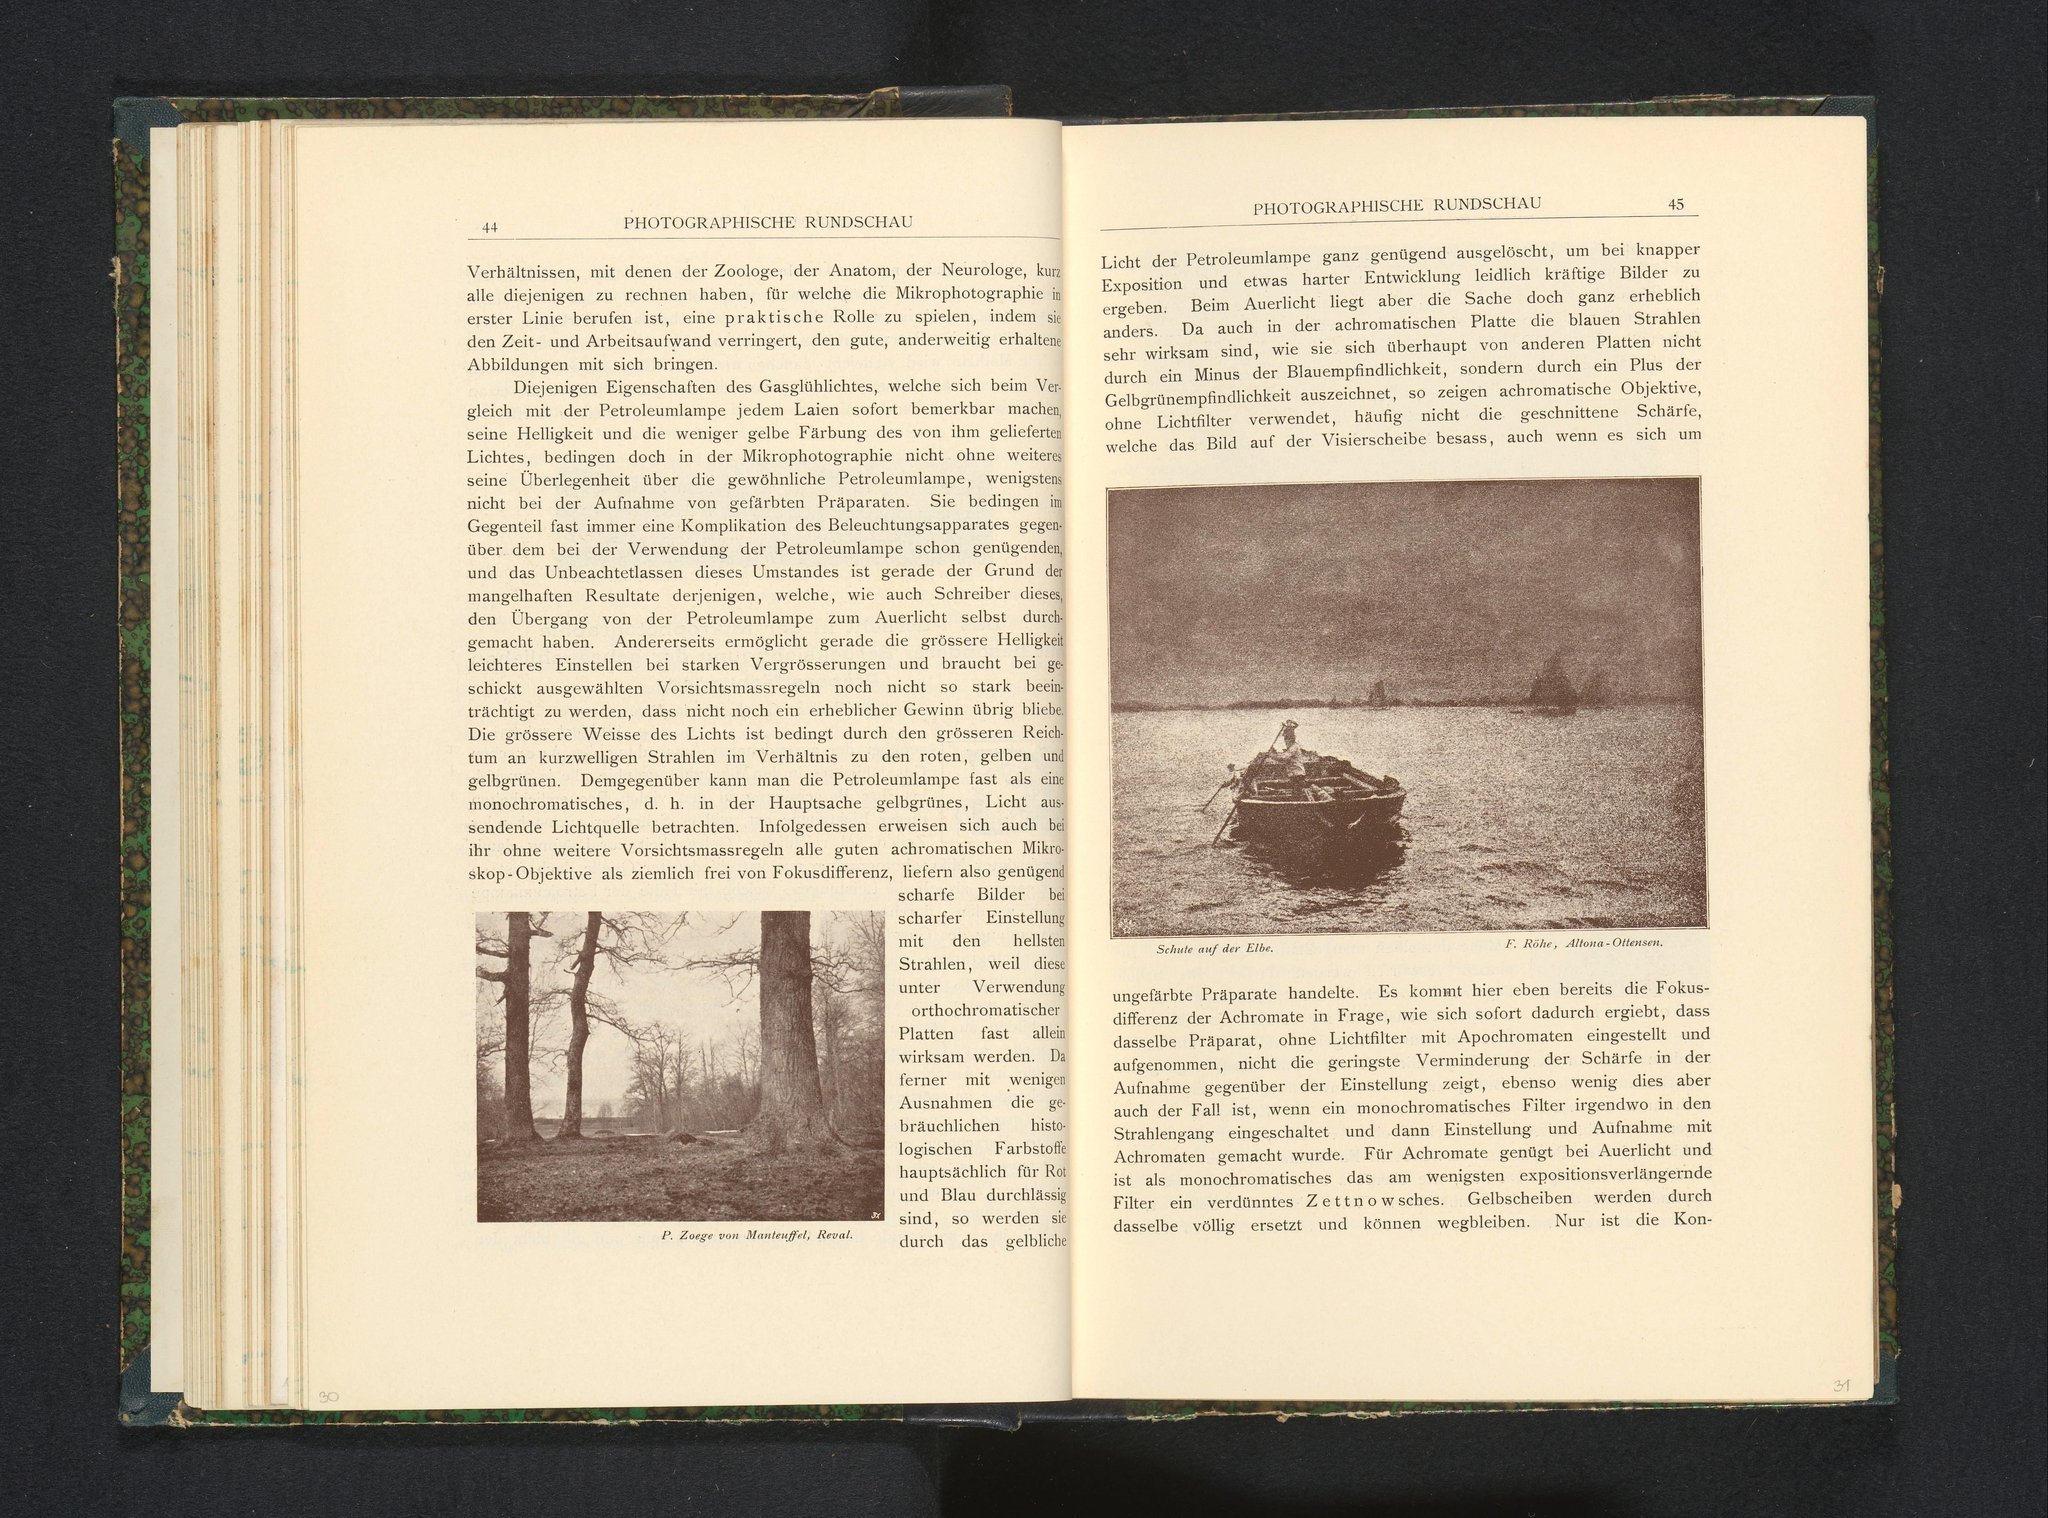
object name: page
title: Schute auf der Elbe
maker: f. röhe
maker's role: fotograaf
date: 1894-1899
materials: paper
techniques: autotype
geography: berlin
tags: rowing-boat, canoe, etc., sea (seascape)